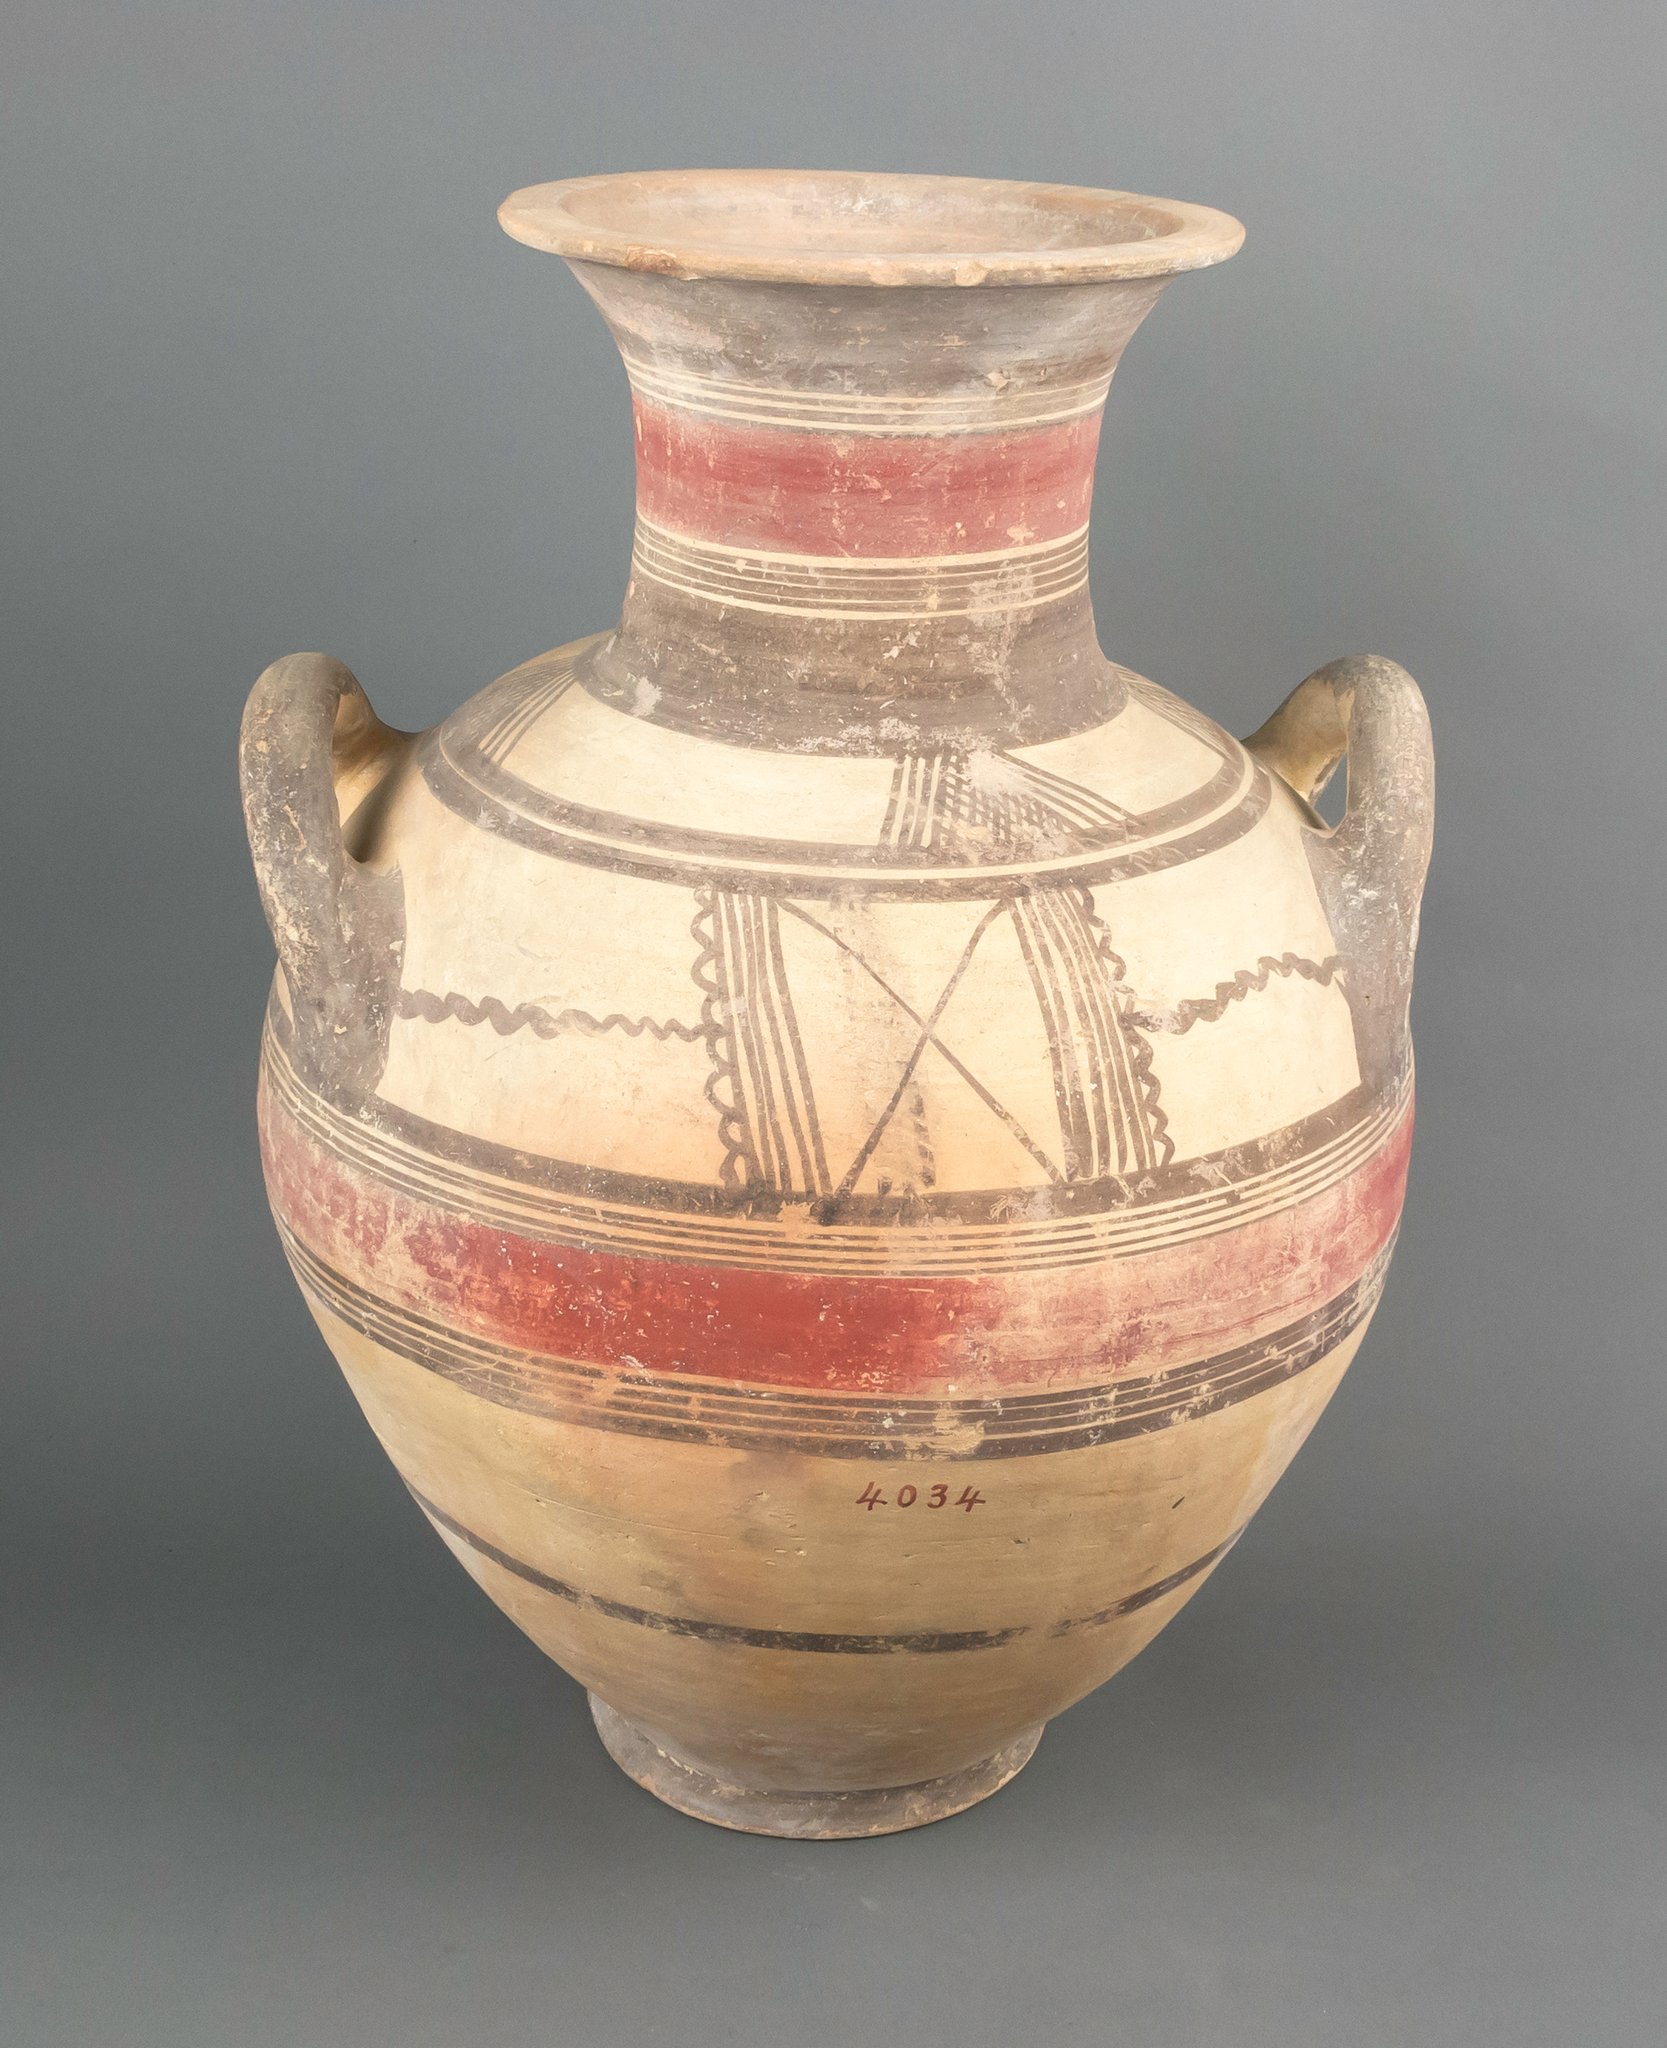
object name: amphora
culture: cypriot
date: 950-850 BCE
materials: terracotta